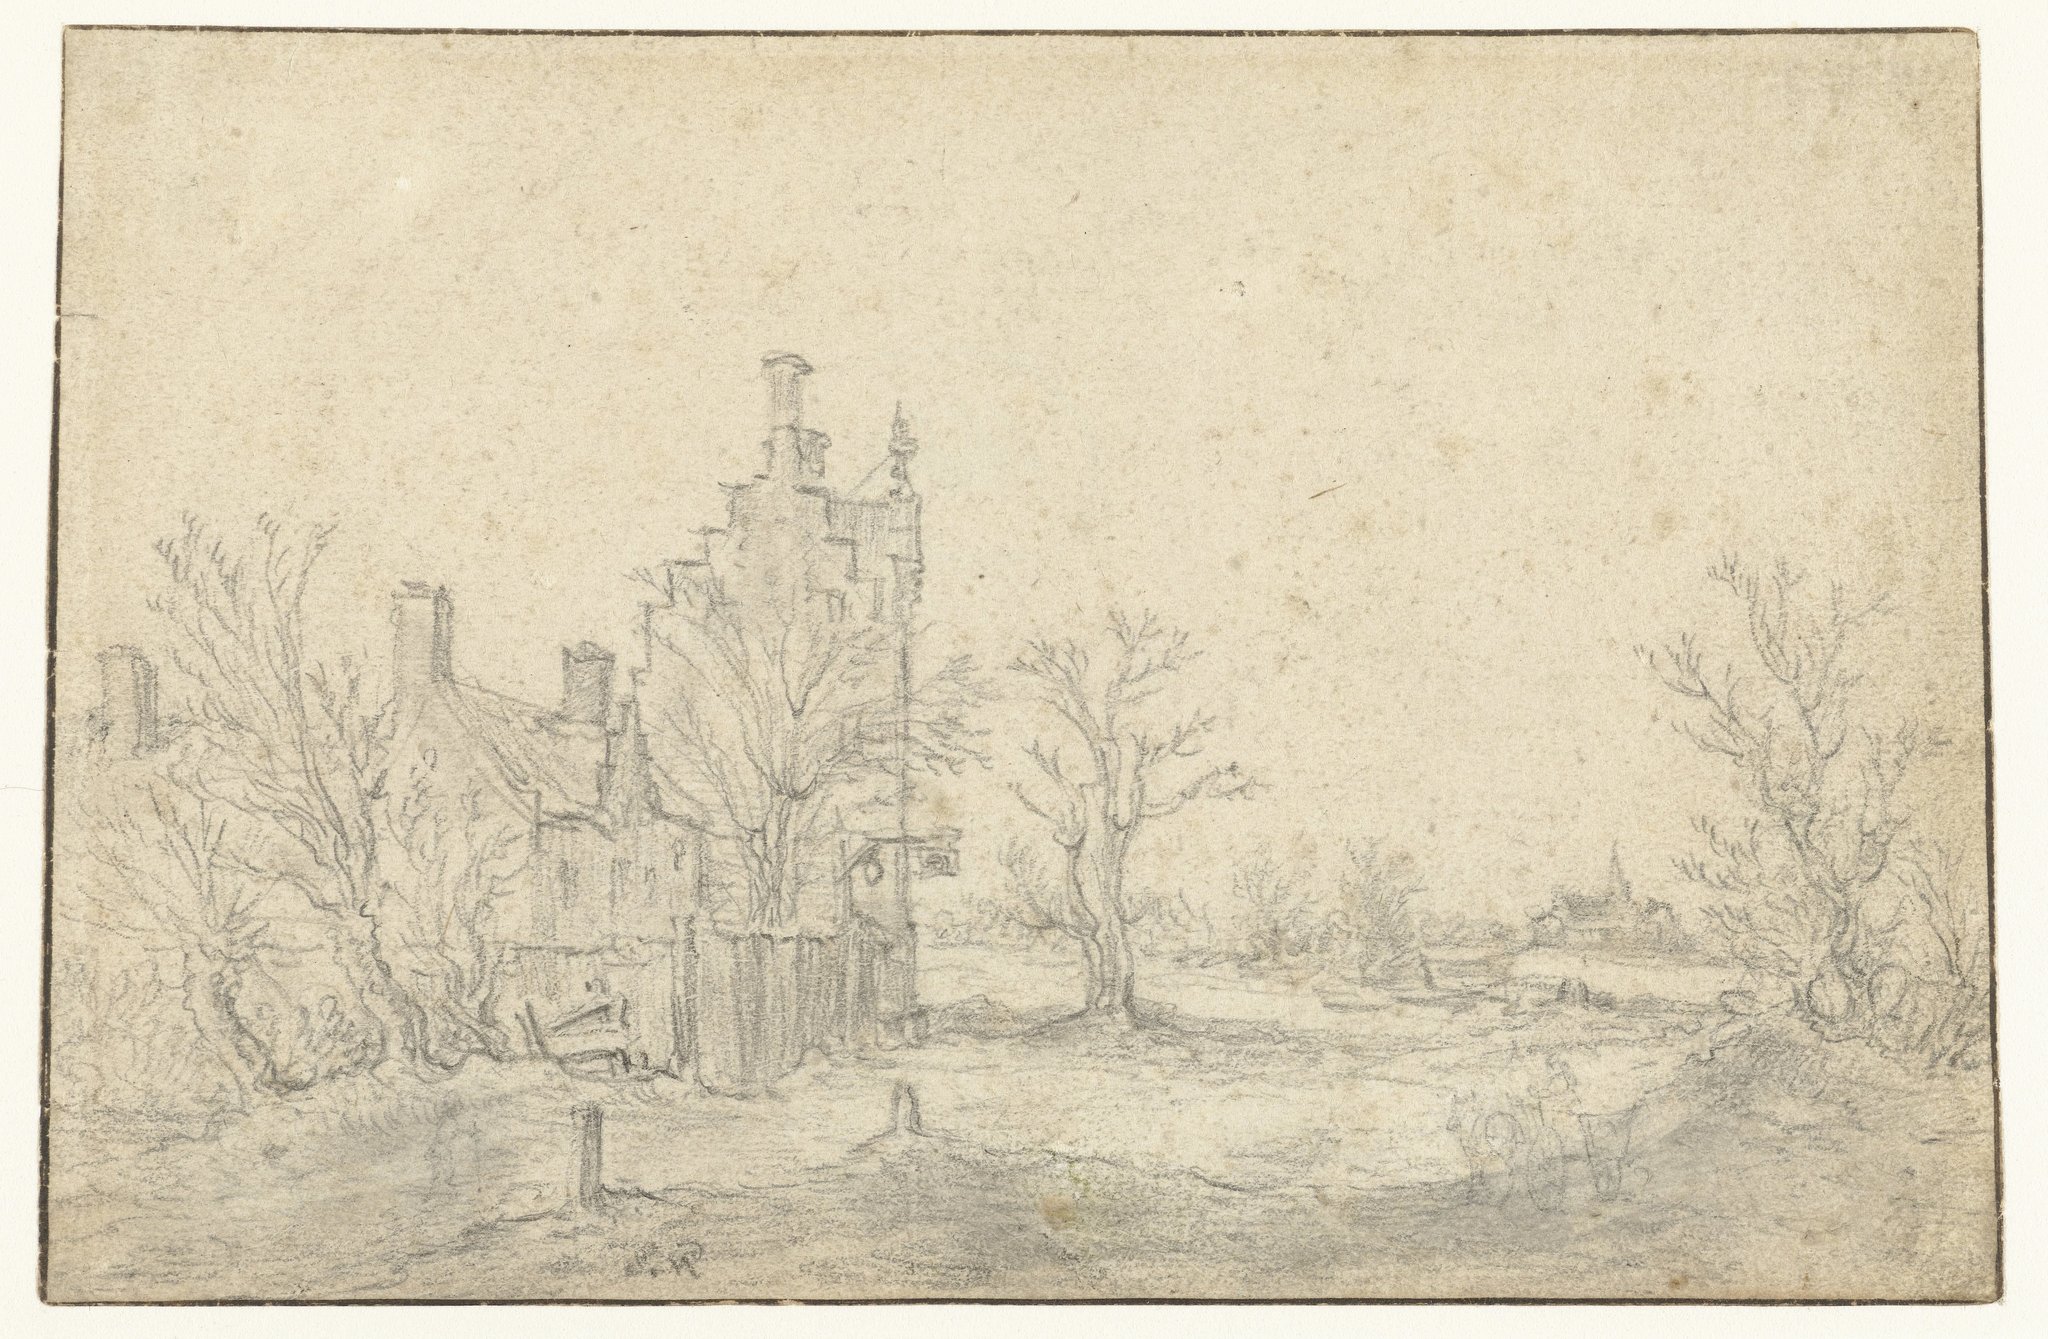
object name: drawing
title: Hoog gebouw in een landschap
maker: salomon van ruysdael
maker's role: draughtsman, painter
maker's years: 1600-1670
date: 1610-1670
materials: paper, pencil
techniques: brush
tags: city-view, and landscape with man-made constructions, hotel, hostelry, inn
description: Hoog gebouw met trapgevels en uithangbord in een landschap.